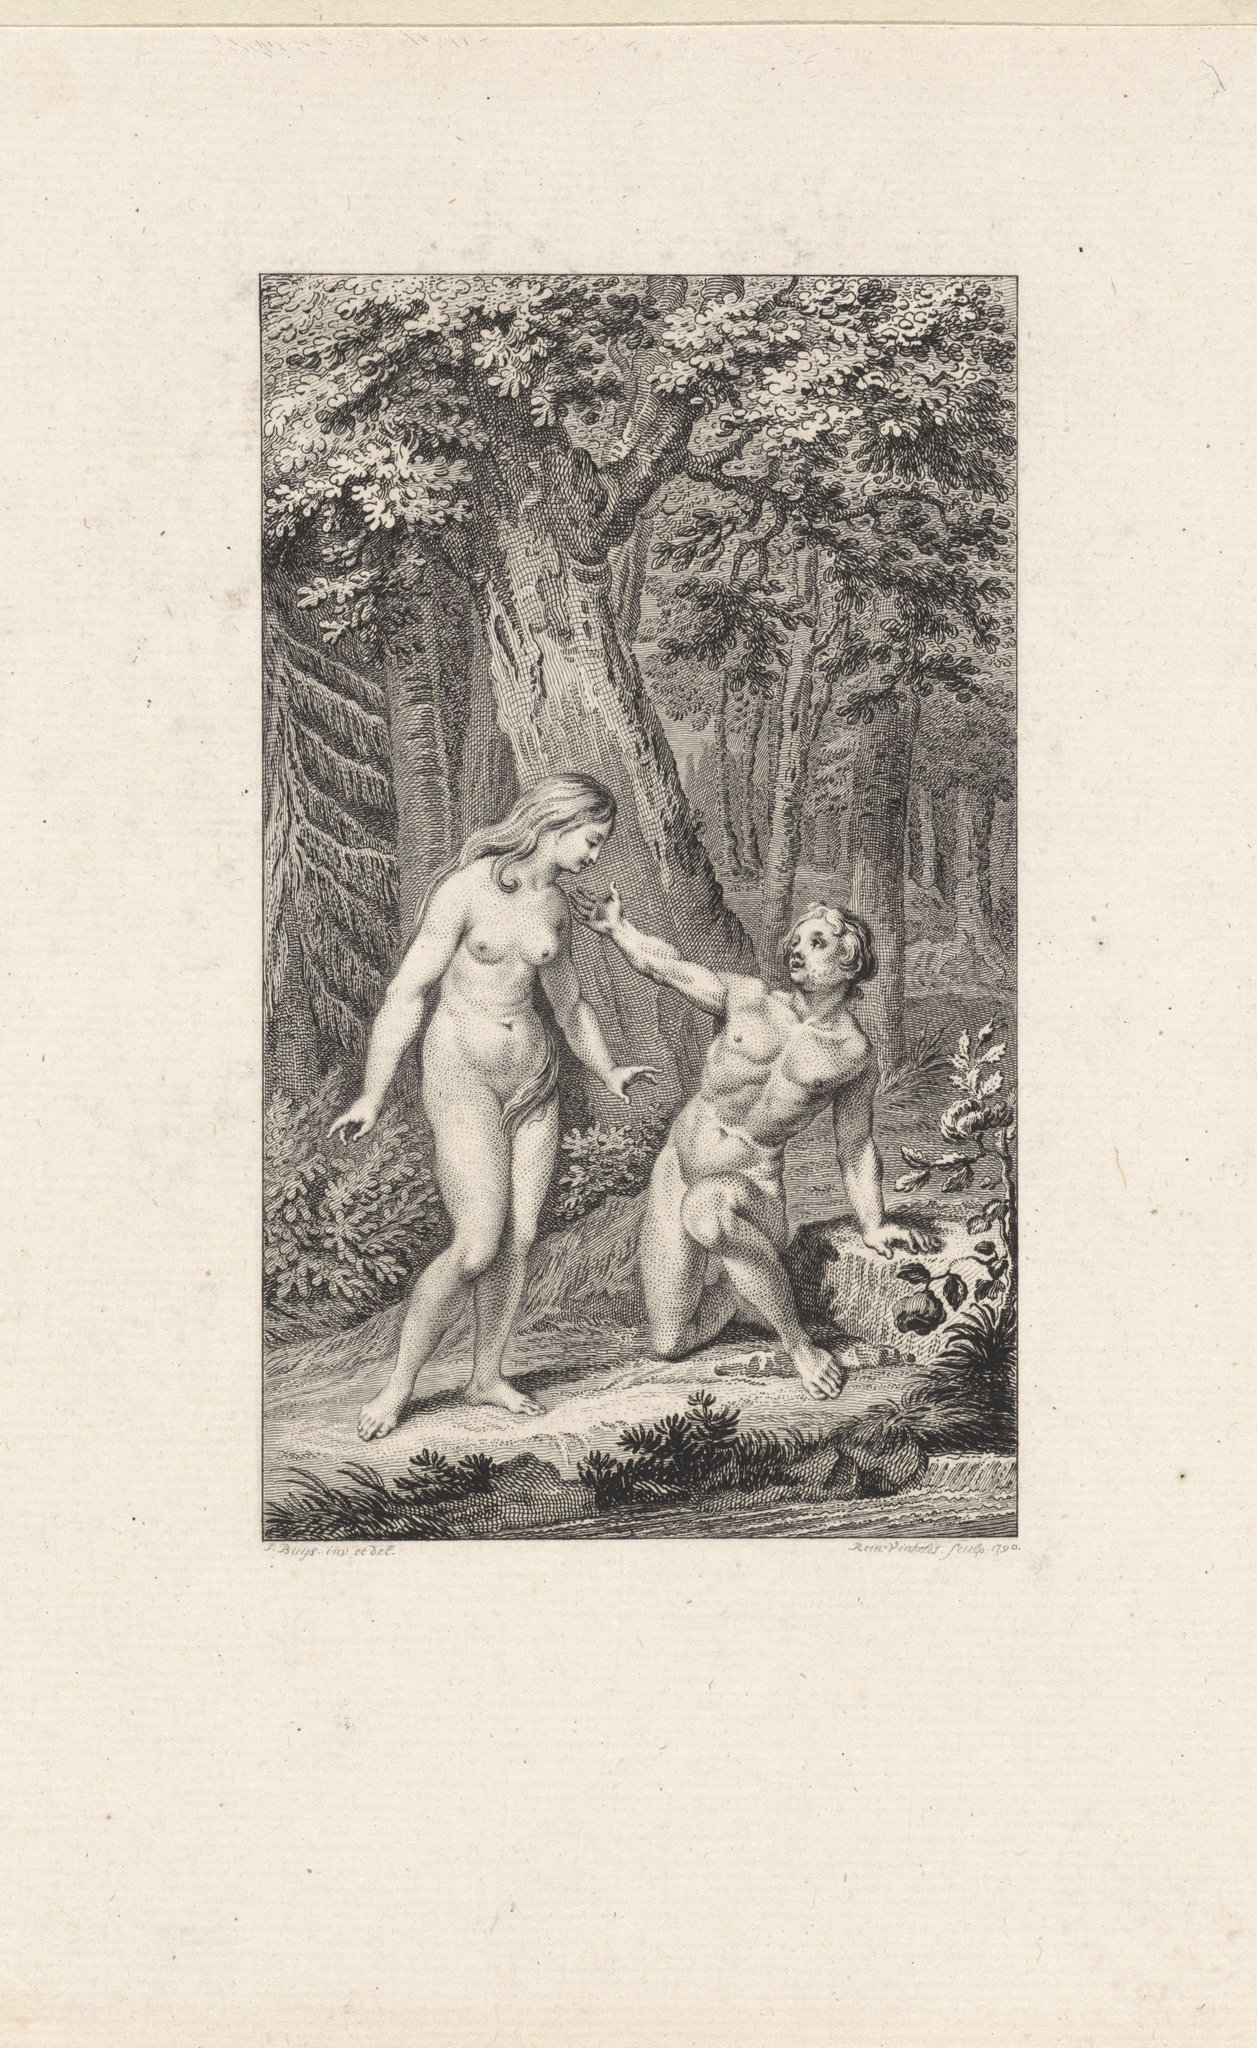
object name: print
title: Schepping van Eva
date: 1797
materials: paper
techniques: engraving, etching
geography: amsterdam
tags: creation of eve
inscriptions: collector's mark: Lugt 240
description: Adam ontwaakt uit zijn slaap en ziet Eva die zojuist geschapen is uit zijn rib.